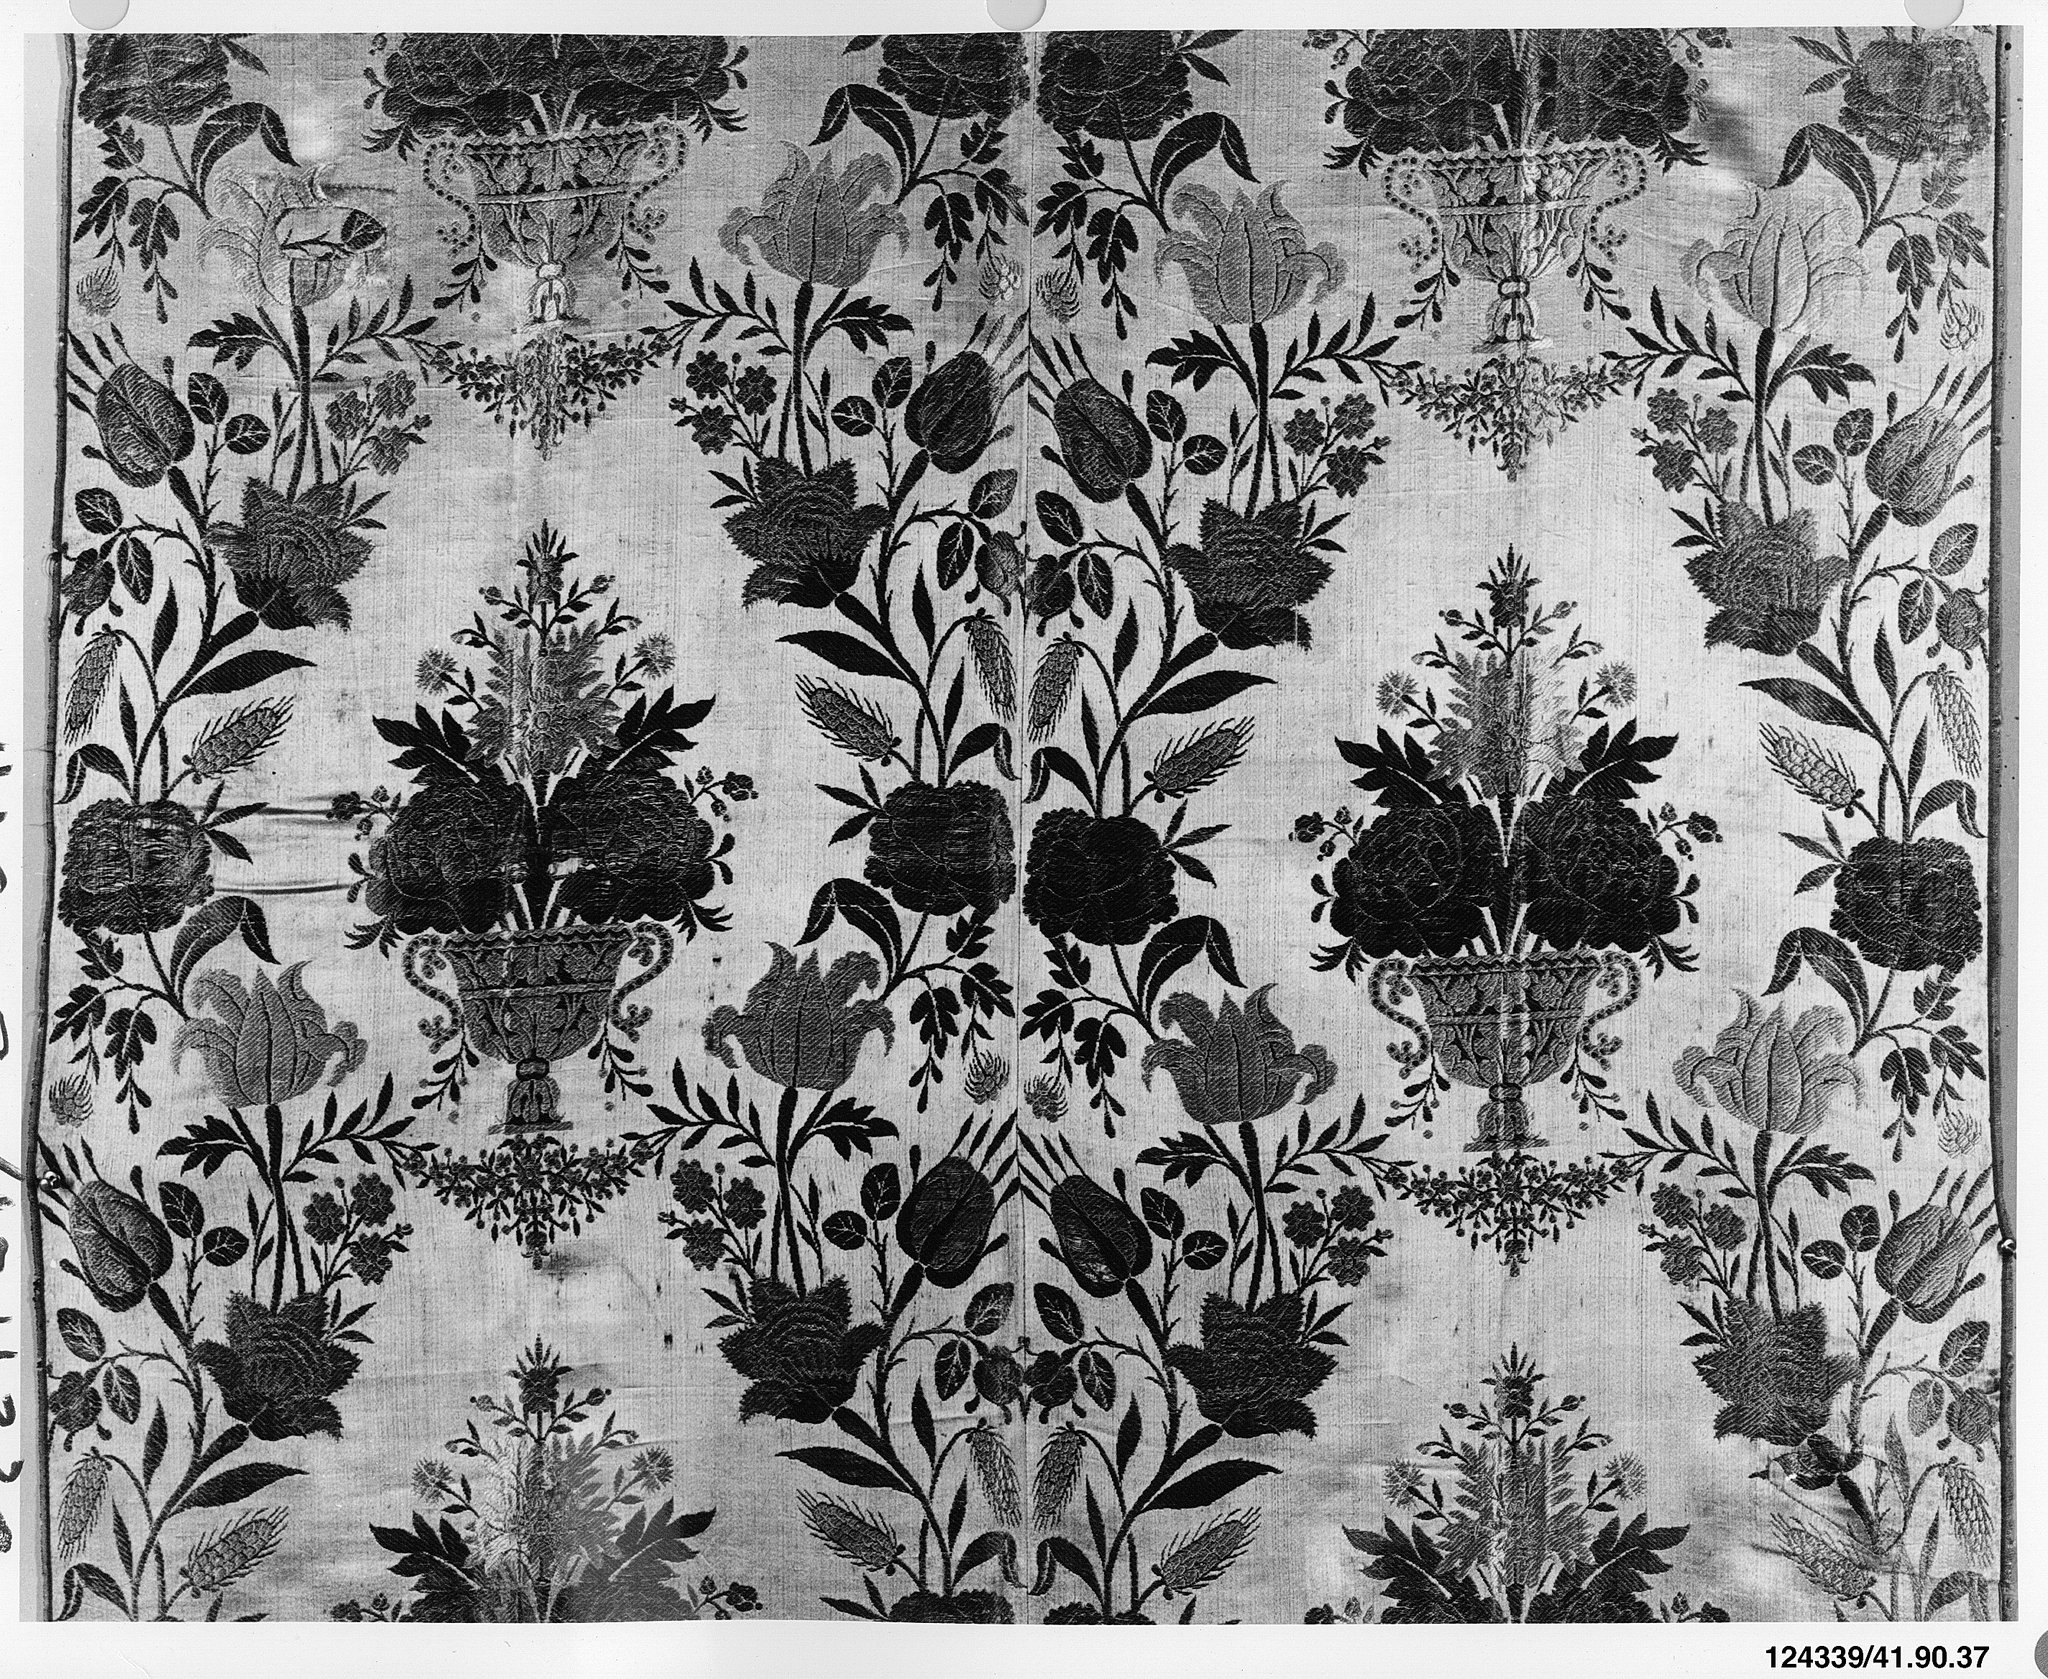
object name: piece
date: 1730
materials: silk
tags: flowers,leaves